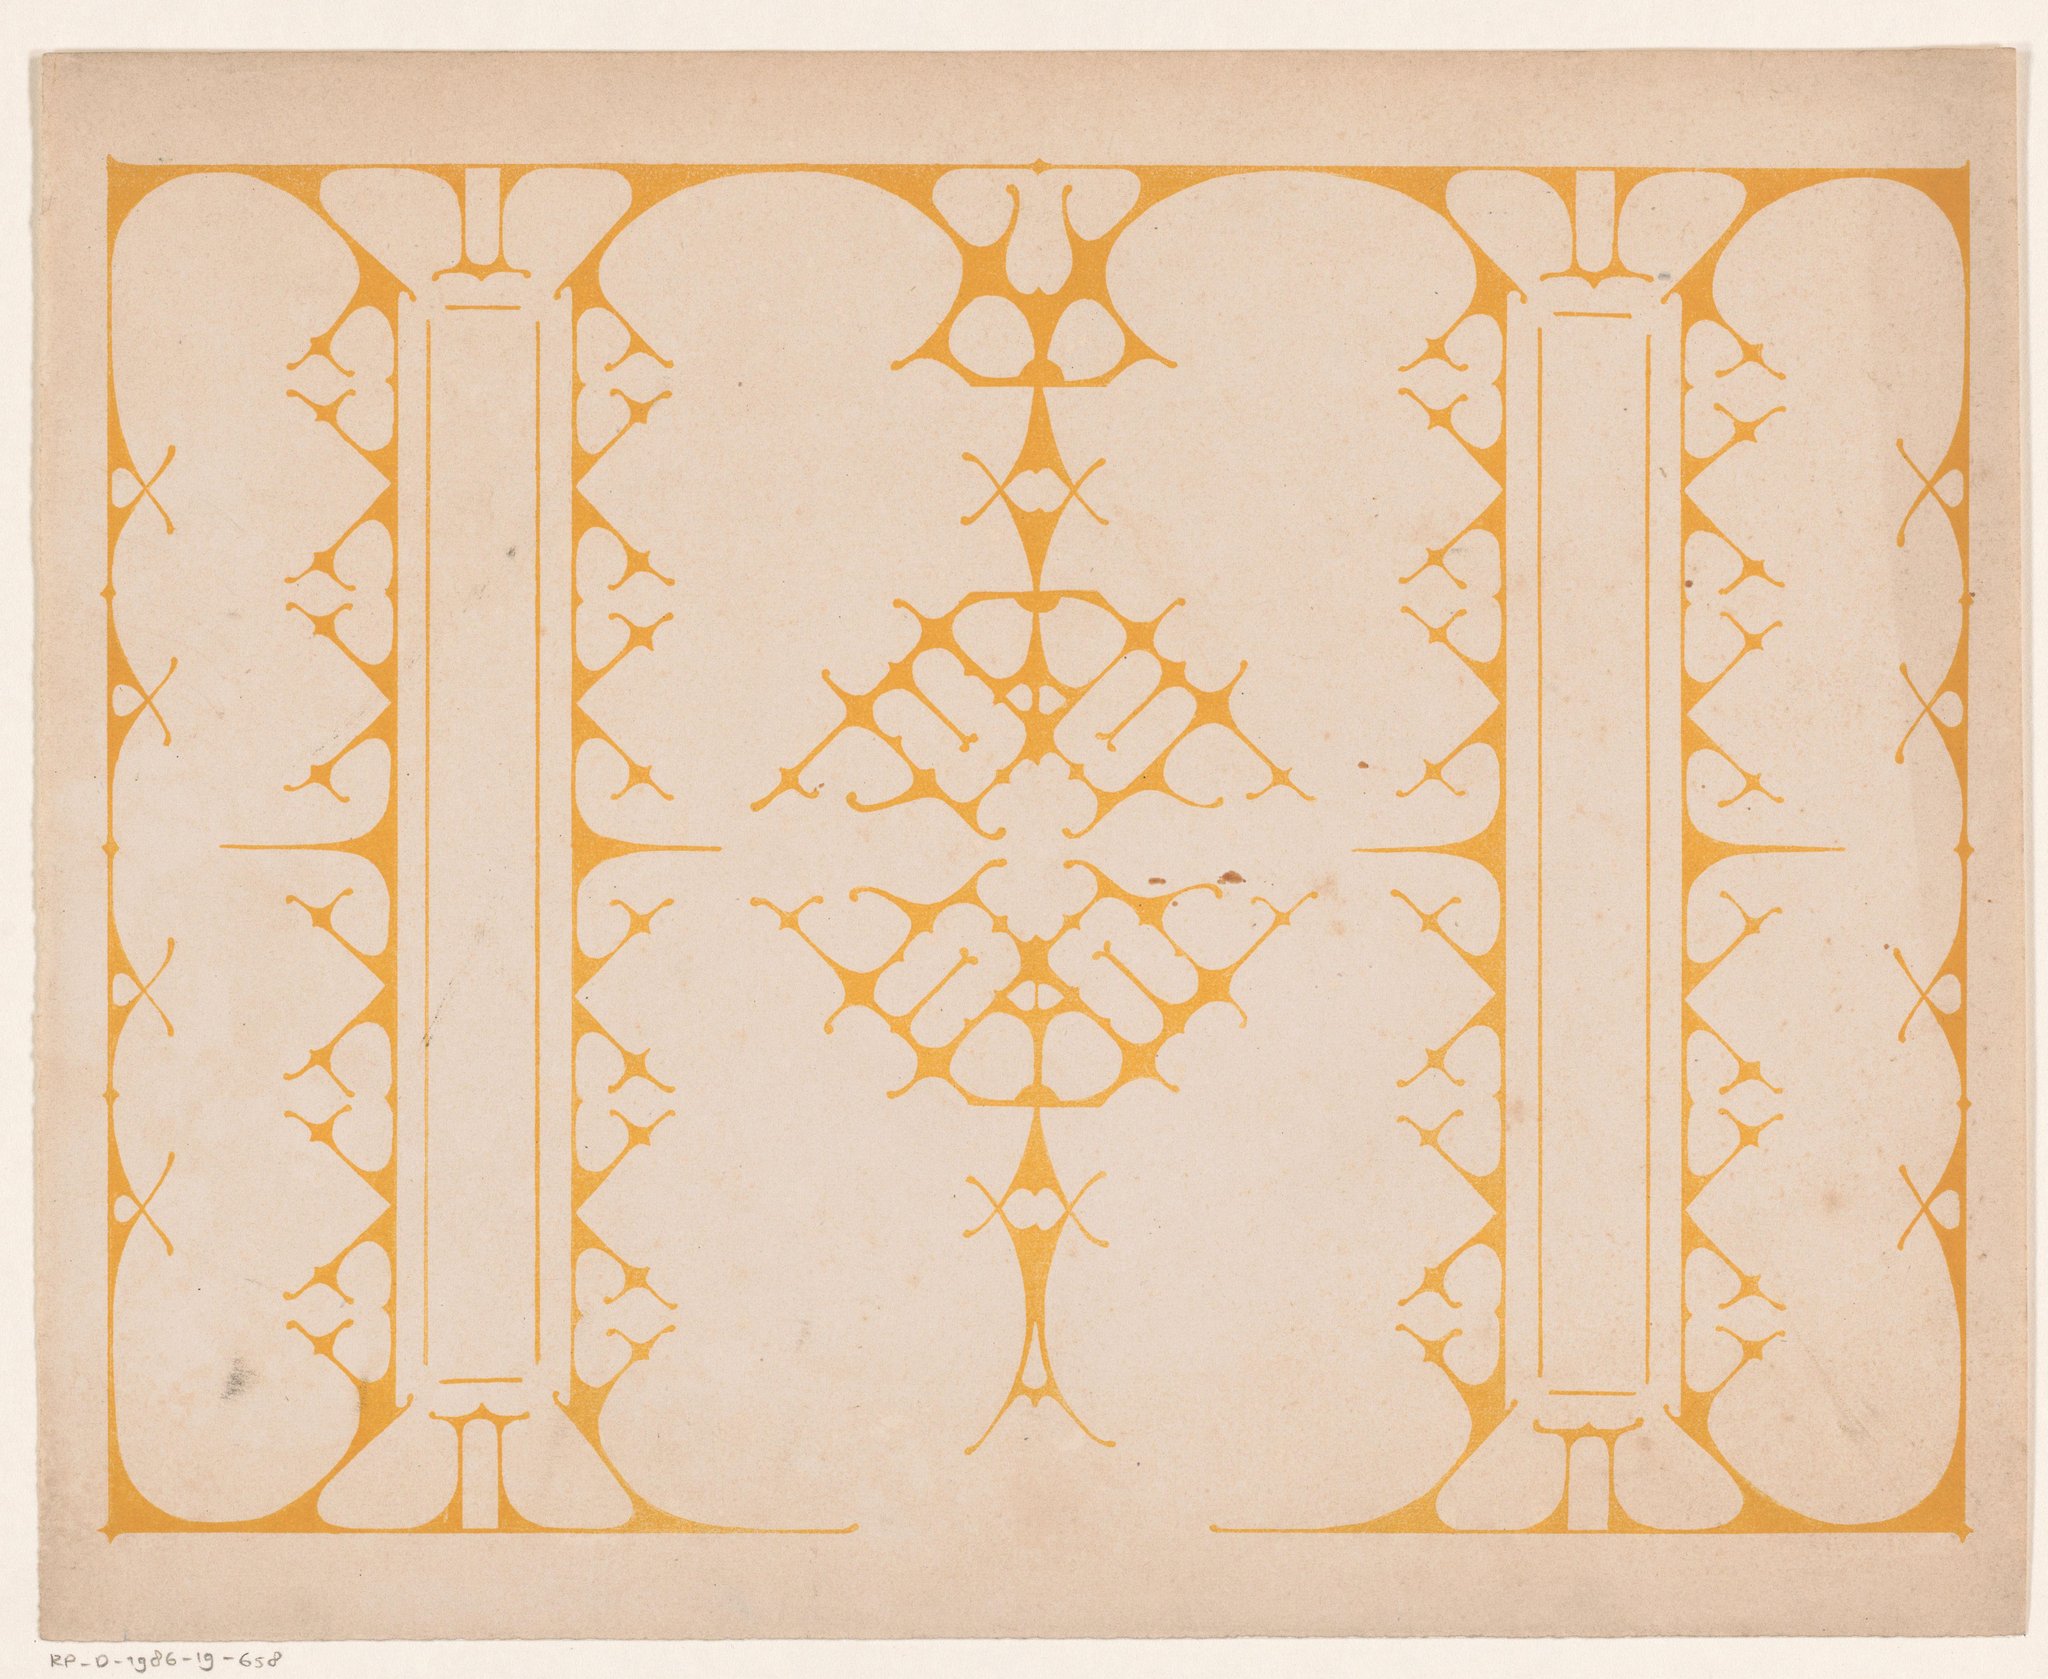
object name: photomechanical print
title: Ontwerp voor een schutblad met titelkaders en ornamenten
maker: reinier willem petrus de vries (1874-1953)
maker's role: draughtsman, print maker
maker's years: 1874-1953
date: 1884-1952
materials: paper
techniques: printing block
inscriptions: collector's mark: ‘R:MVS.’